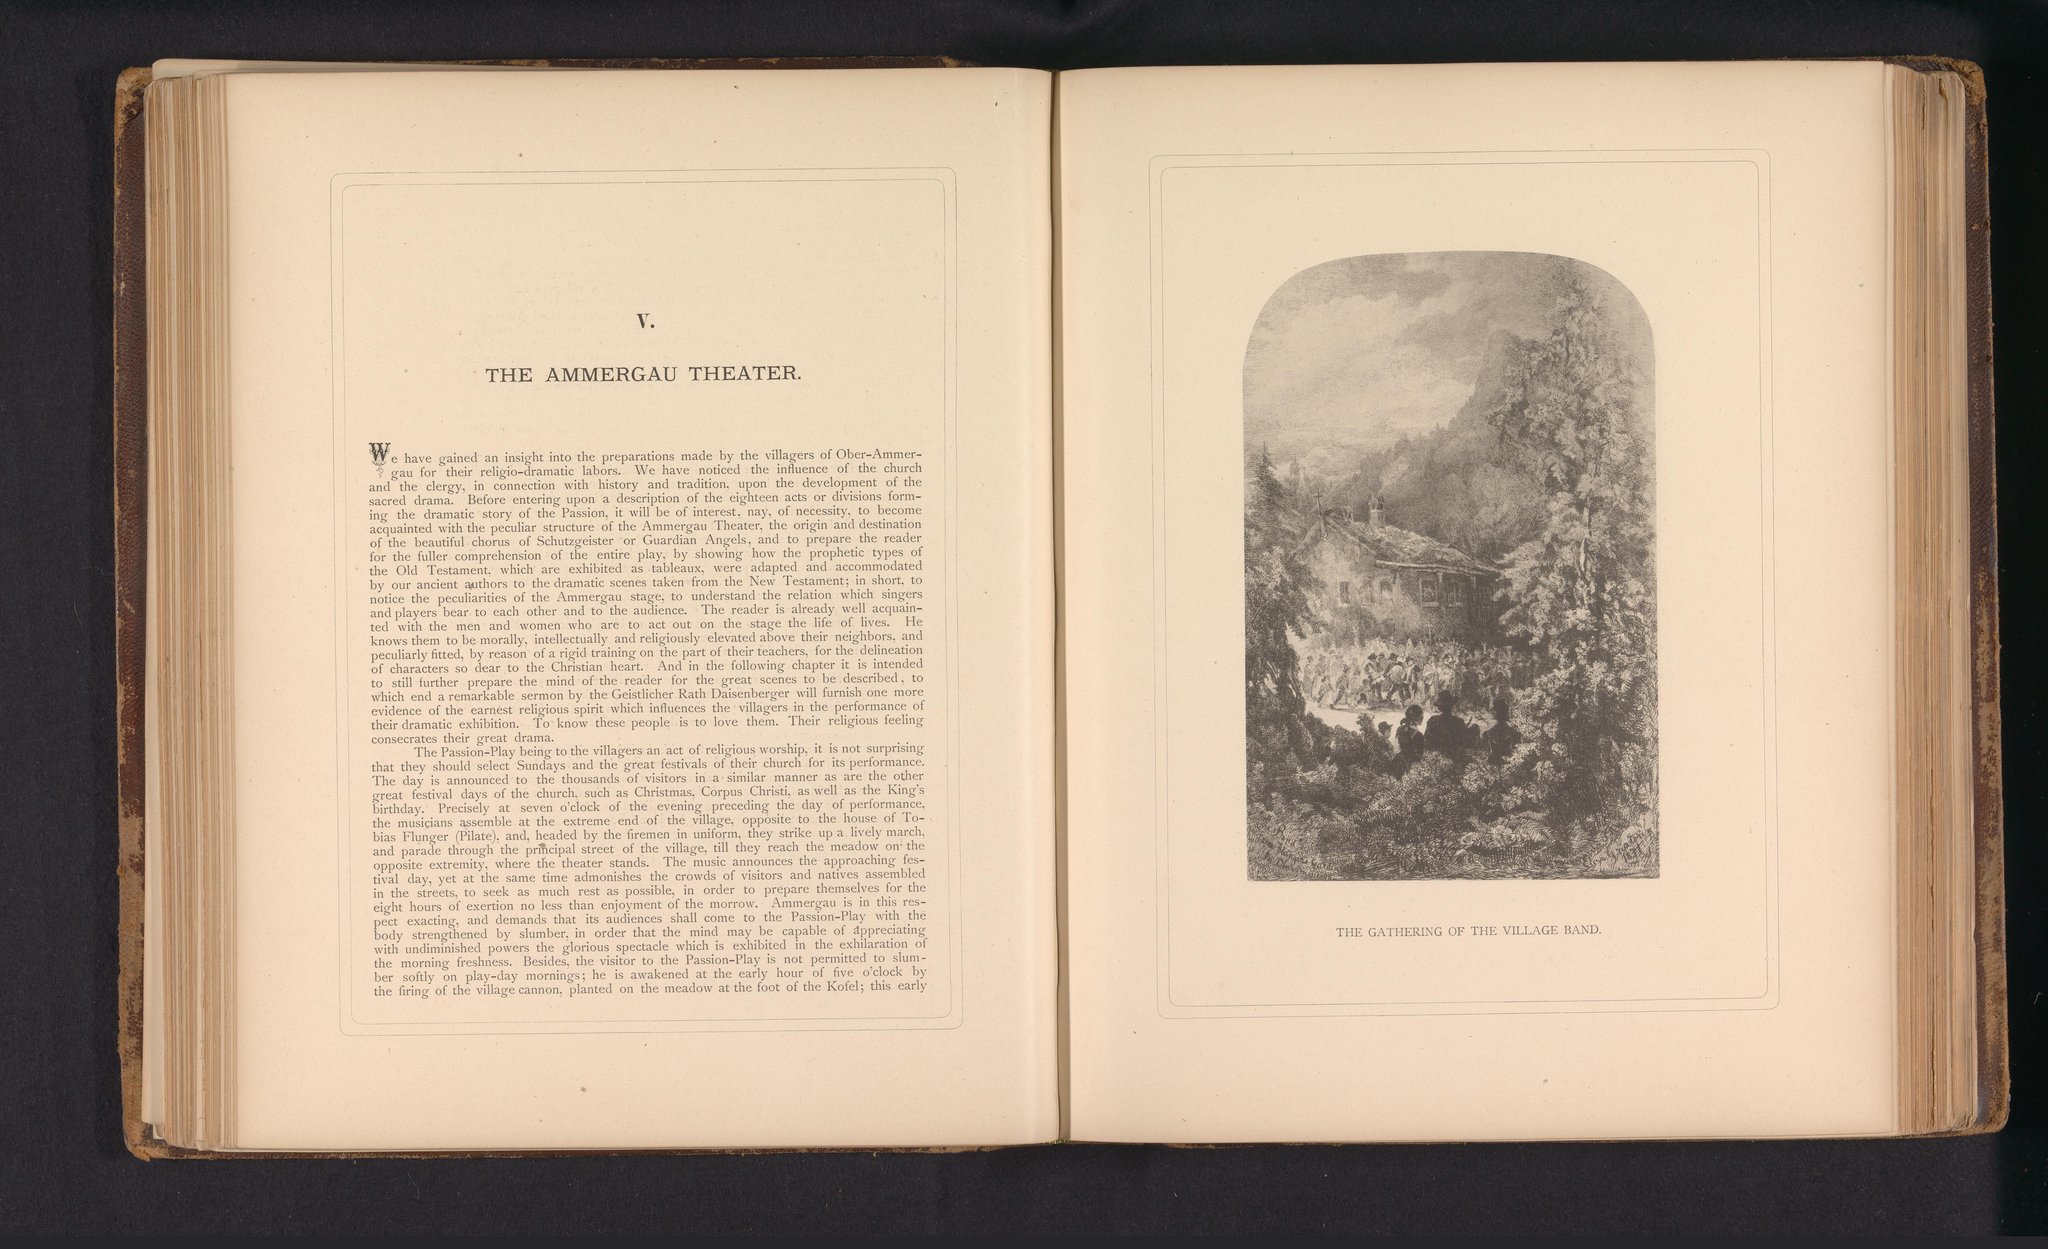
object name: reproduction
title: The gathering of the village band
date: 1871-1873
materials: paper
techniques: photograph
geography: oberammergau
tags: instrumental popular music